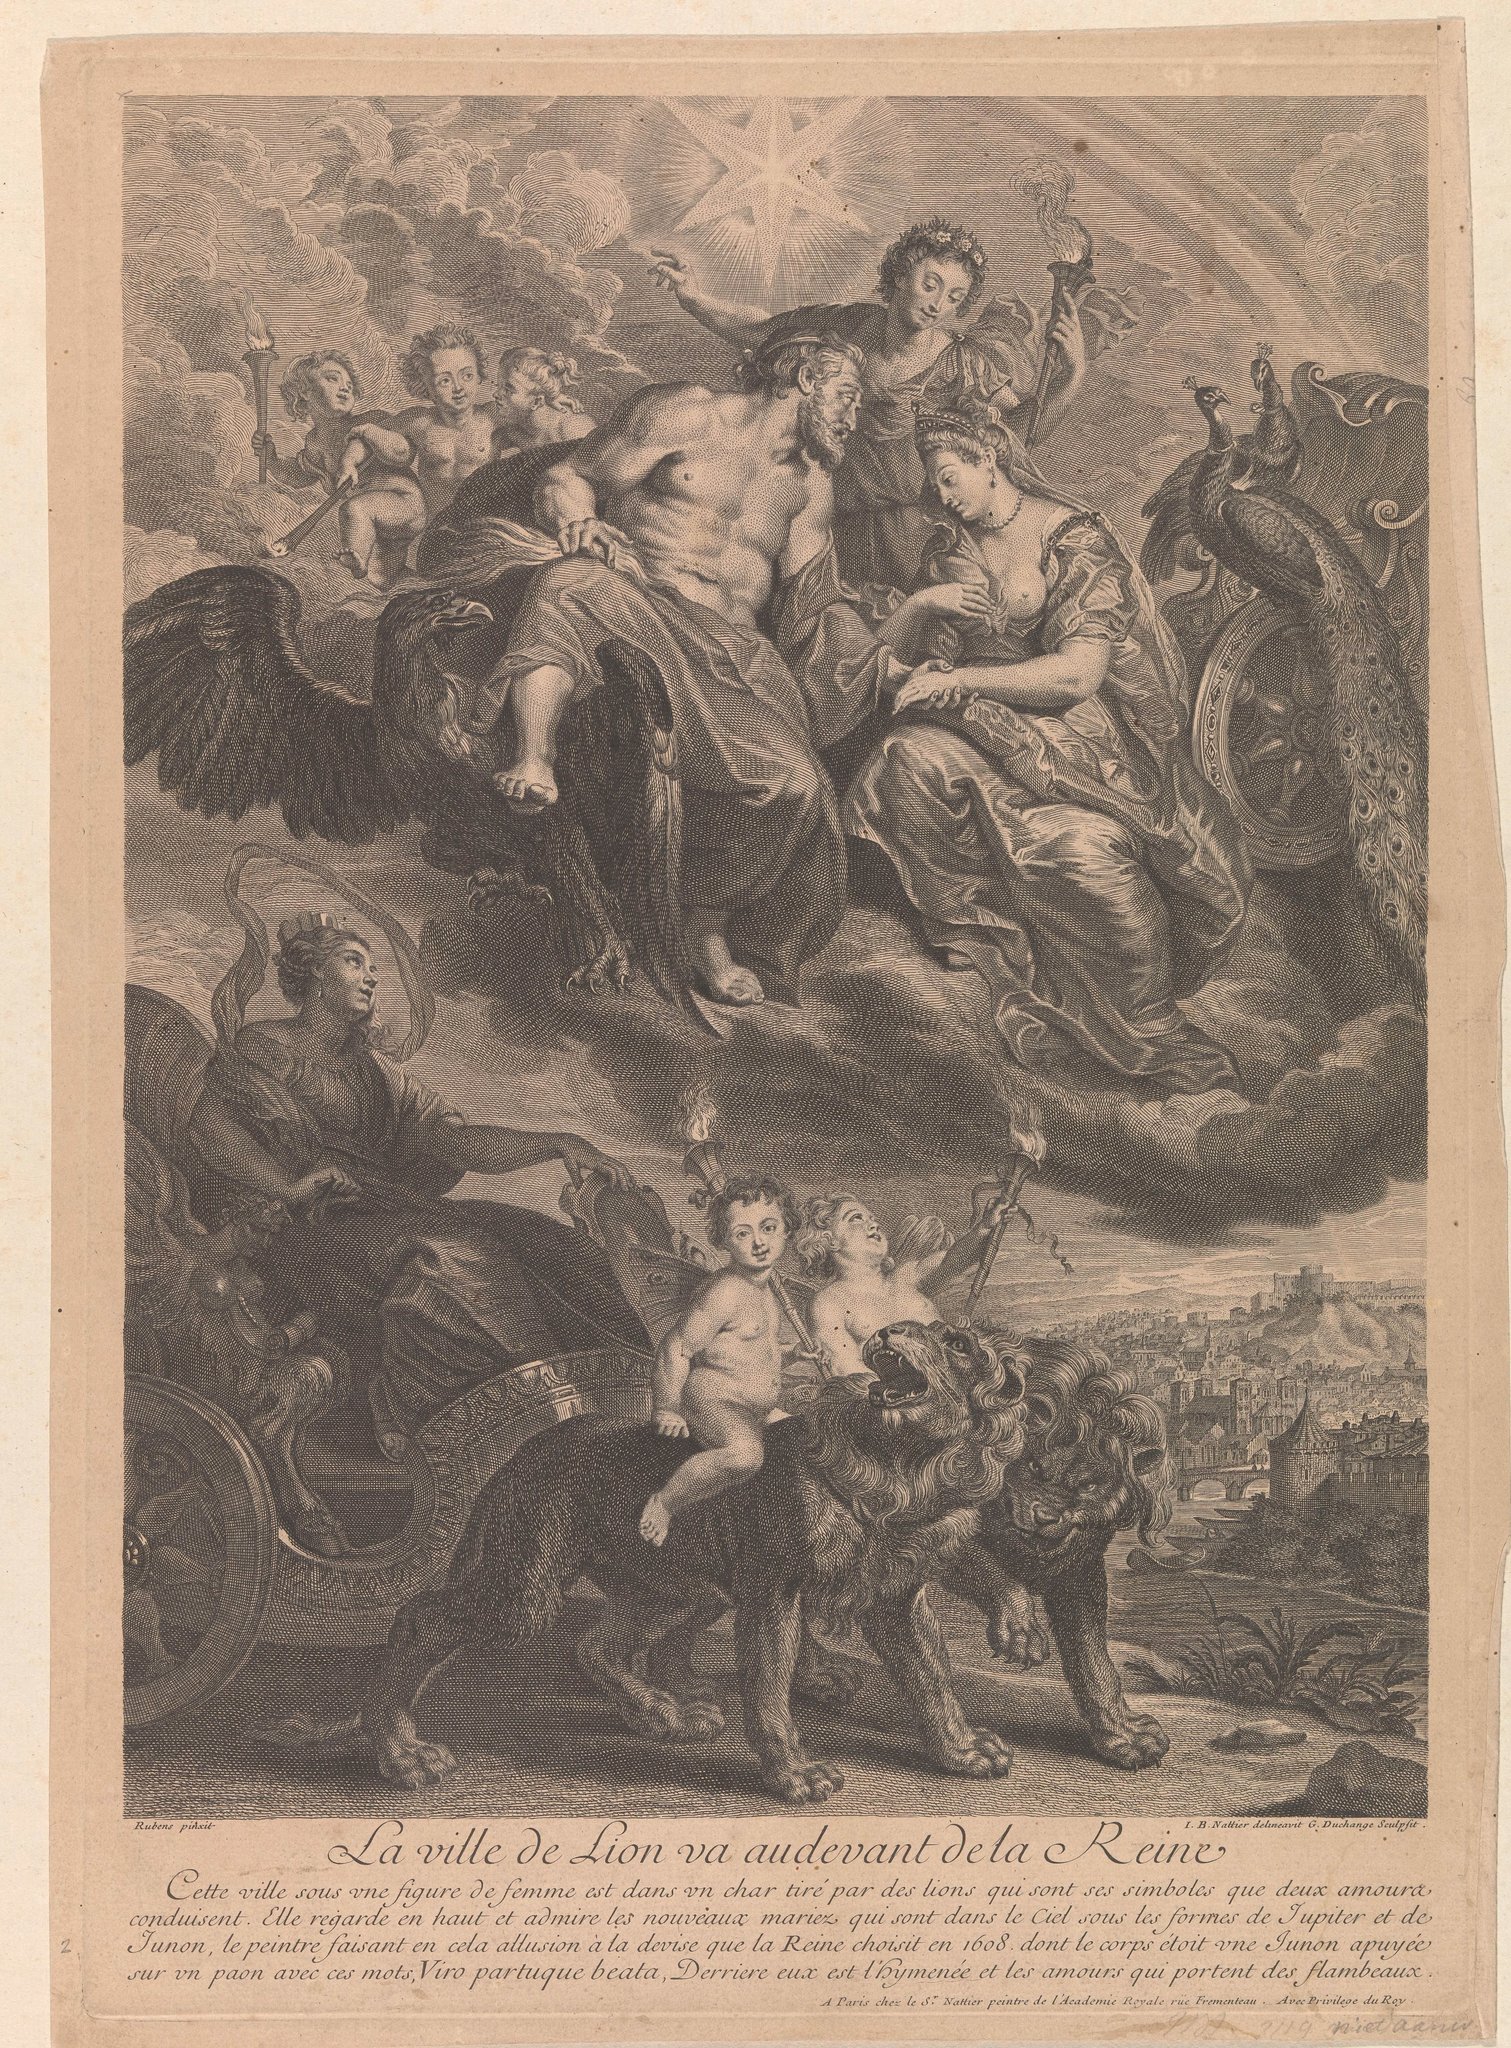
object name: album leaf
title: La ville de Lion va audevant de la Reine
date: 1672-1757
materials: paper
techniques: engraving, etching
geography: paris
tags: print maker, maria de' medici, paris, hendrik iv (koning van frankrijk en navarra), (story of) juno (hera), personification of a city, town-patron(ess), (story of) jupiter (zeus), lyon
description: Stadsmaagd van Lyon in triomfwagen getrokken door twee leeuwen. In de hemel Jupiter en Juno. Allegorie op de ontmoeting van Marie de' Medici met Hendrik IV in Lyon in 1608. Losse prent achterin het album. Deze prent maakt deel uit van een album.